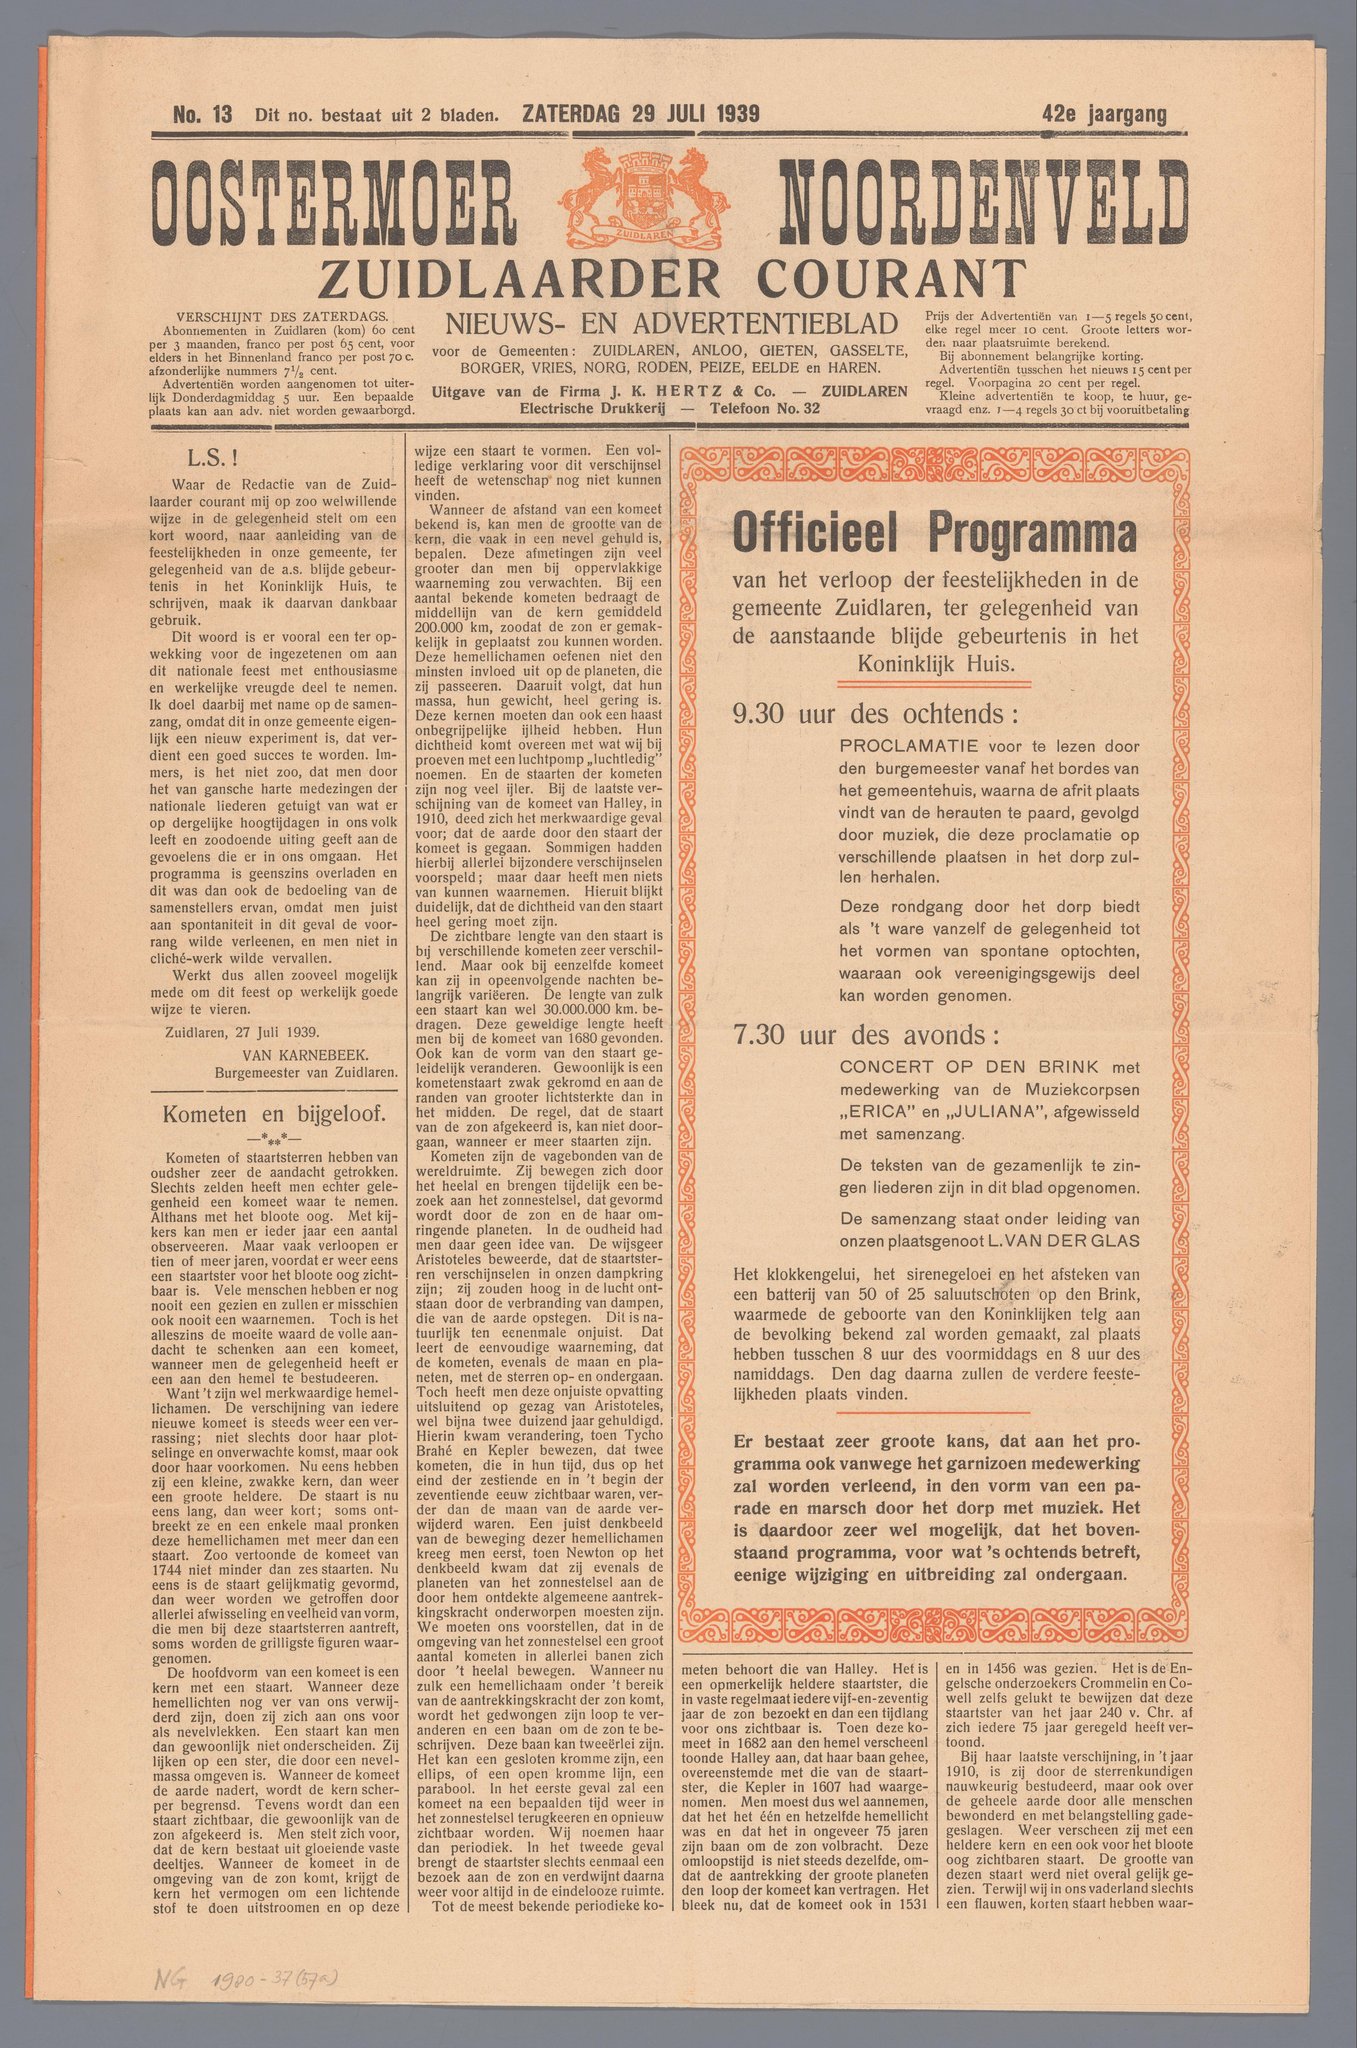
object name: newspaper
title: Zuidlaarder Courant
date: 1939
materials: paper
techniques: printing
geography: zuidlaren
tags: netherlands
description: Krant over de geboorte van prinses Irene, nr 13 van de 42ste jaargang van de Zuidlaarder Courant, 8 pp. waarvan pp. 5 t/m 8 op oranje papier.